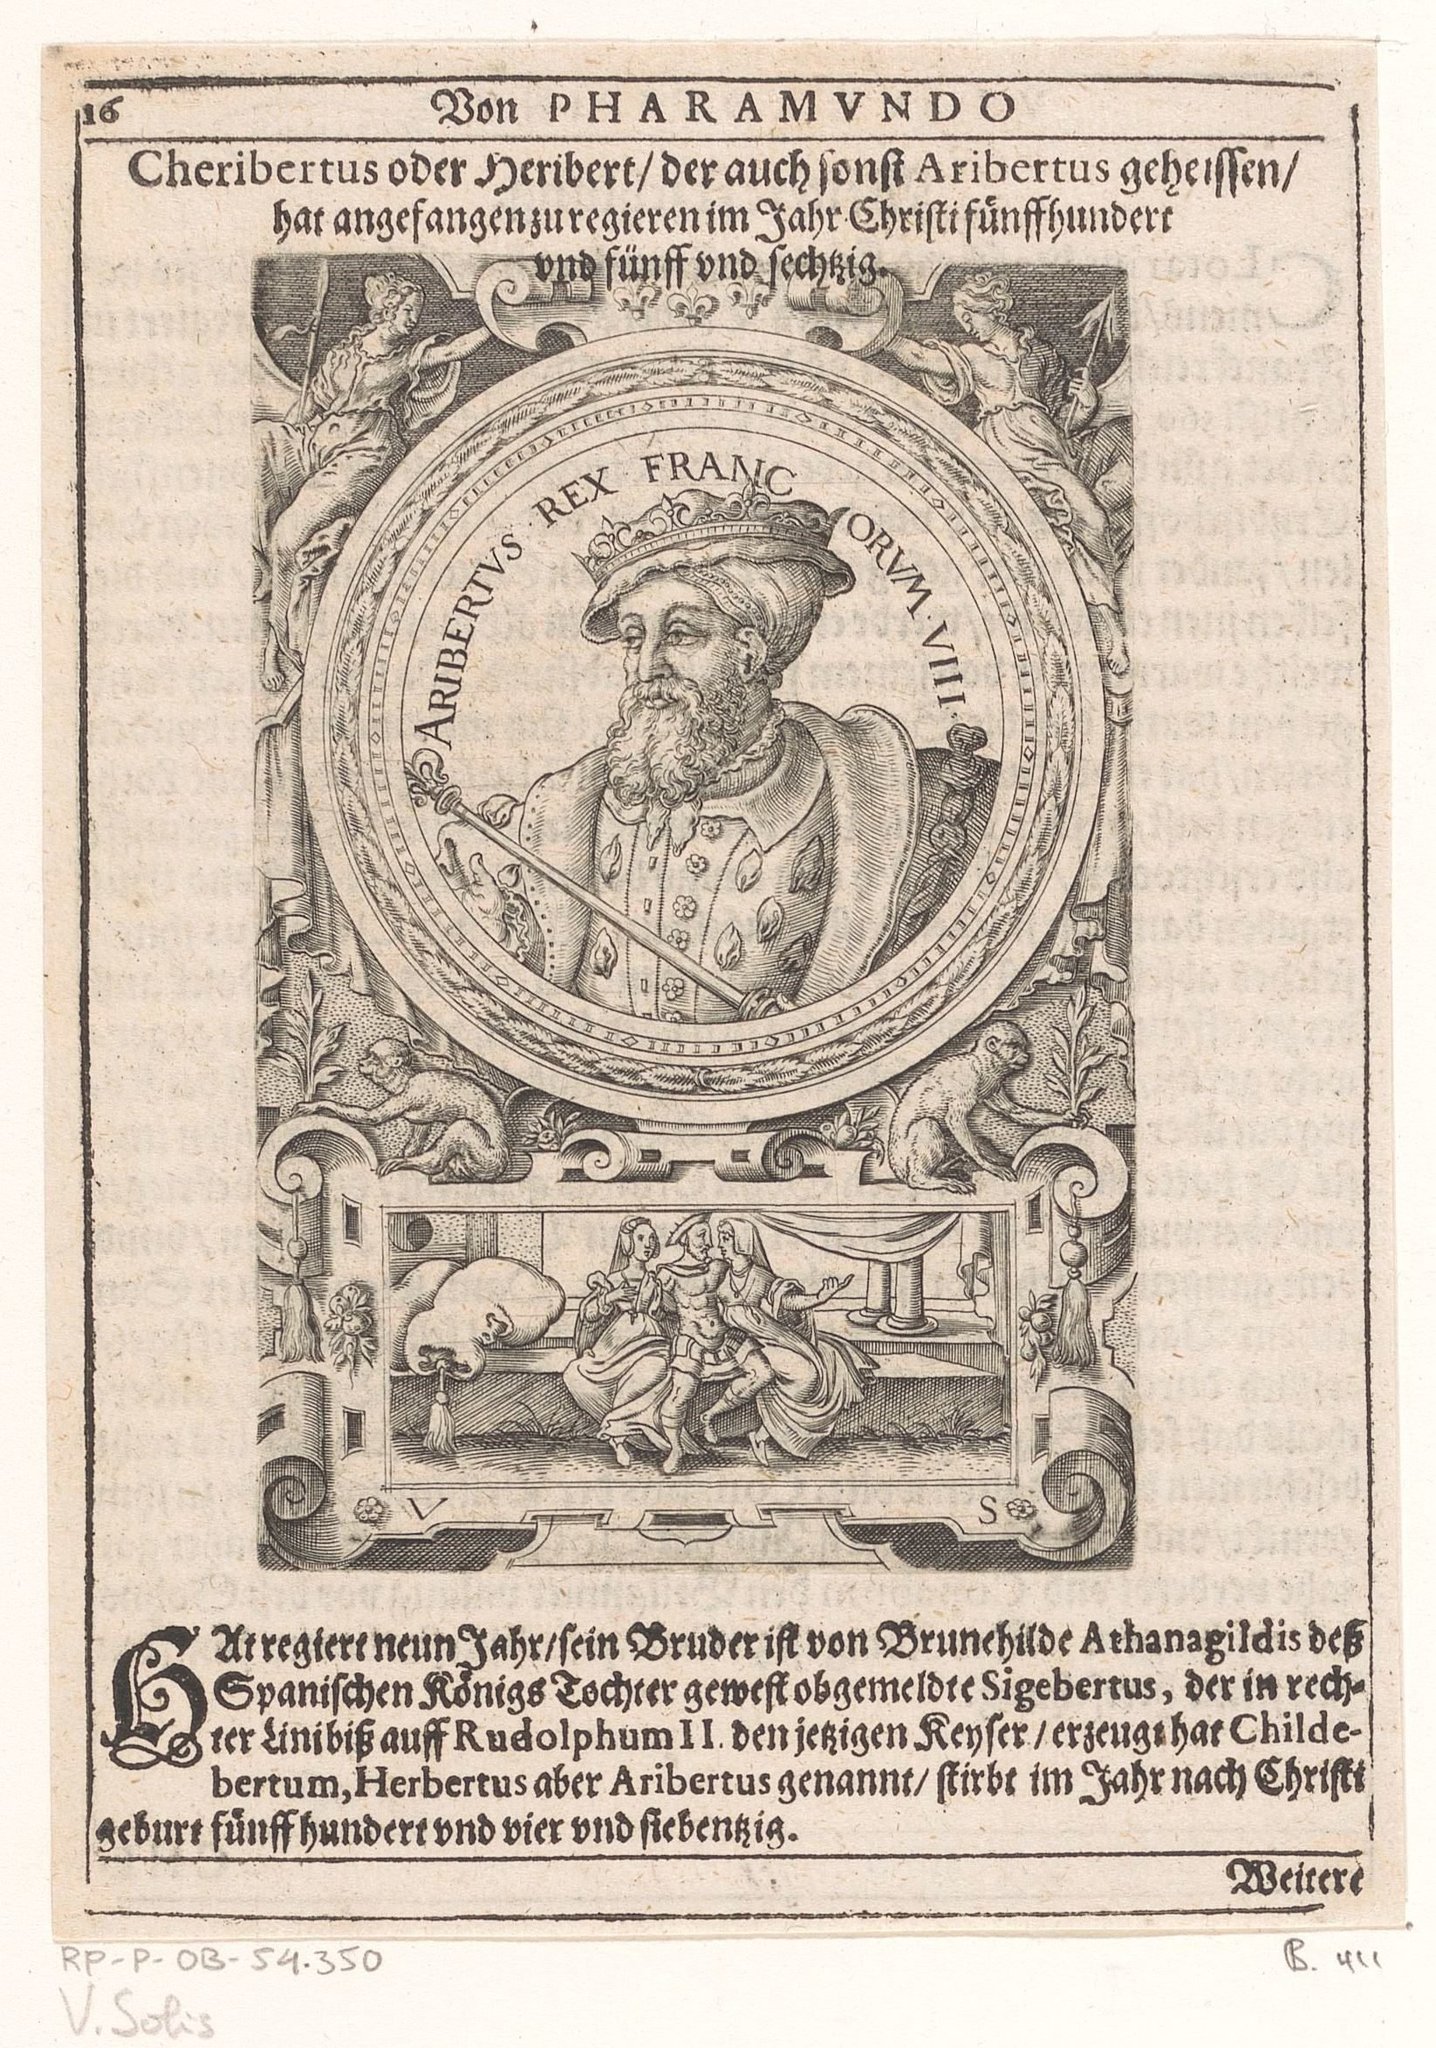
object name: book illustration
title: Portret van Charibert I, koning der Franken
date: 1598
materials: paper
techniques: engraving, etching, intaglio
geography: nuremberg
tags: scrollwork, strapwork ~ ornament, historical persons, ruler, sovereign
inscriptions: collector's mark: Lugt 2228, number: ‘158’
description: Prent afkomstig uit de publicatie: Michael Eizinger. Könige in Frankreich. Keulen: Johann Bussemacher, 1598, p. 16. De publicatie bevat prenten van Jost Amman en Virgil Solis.